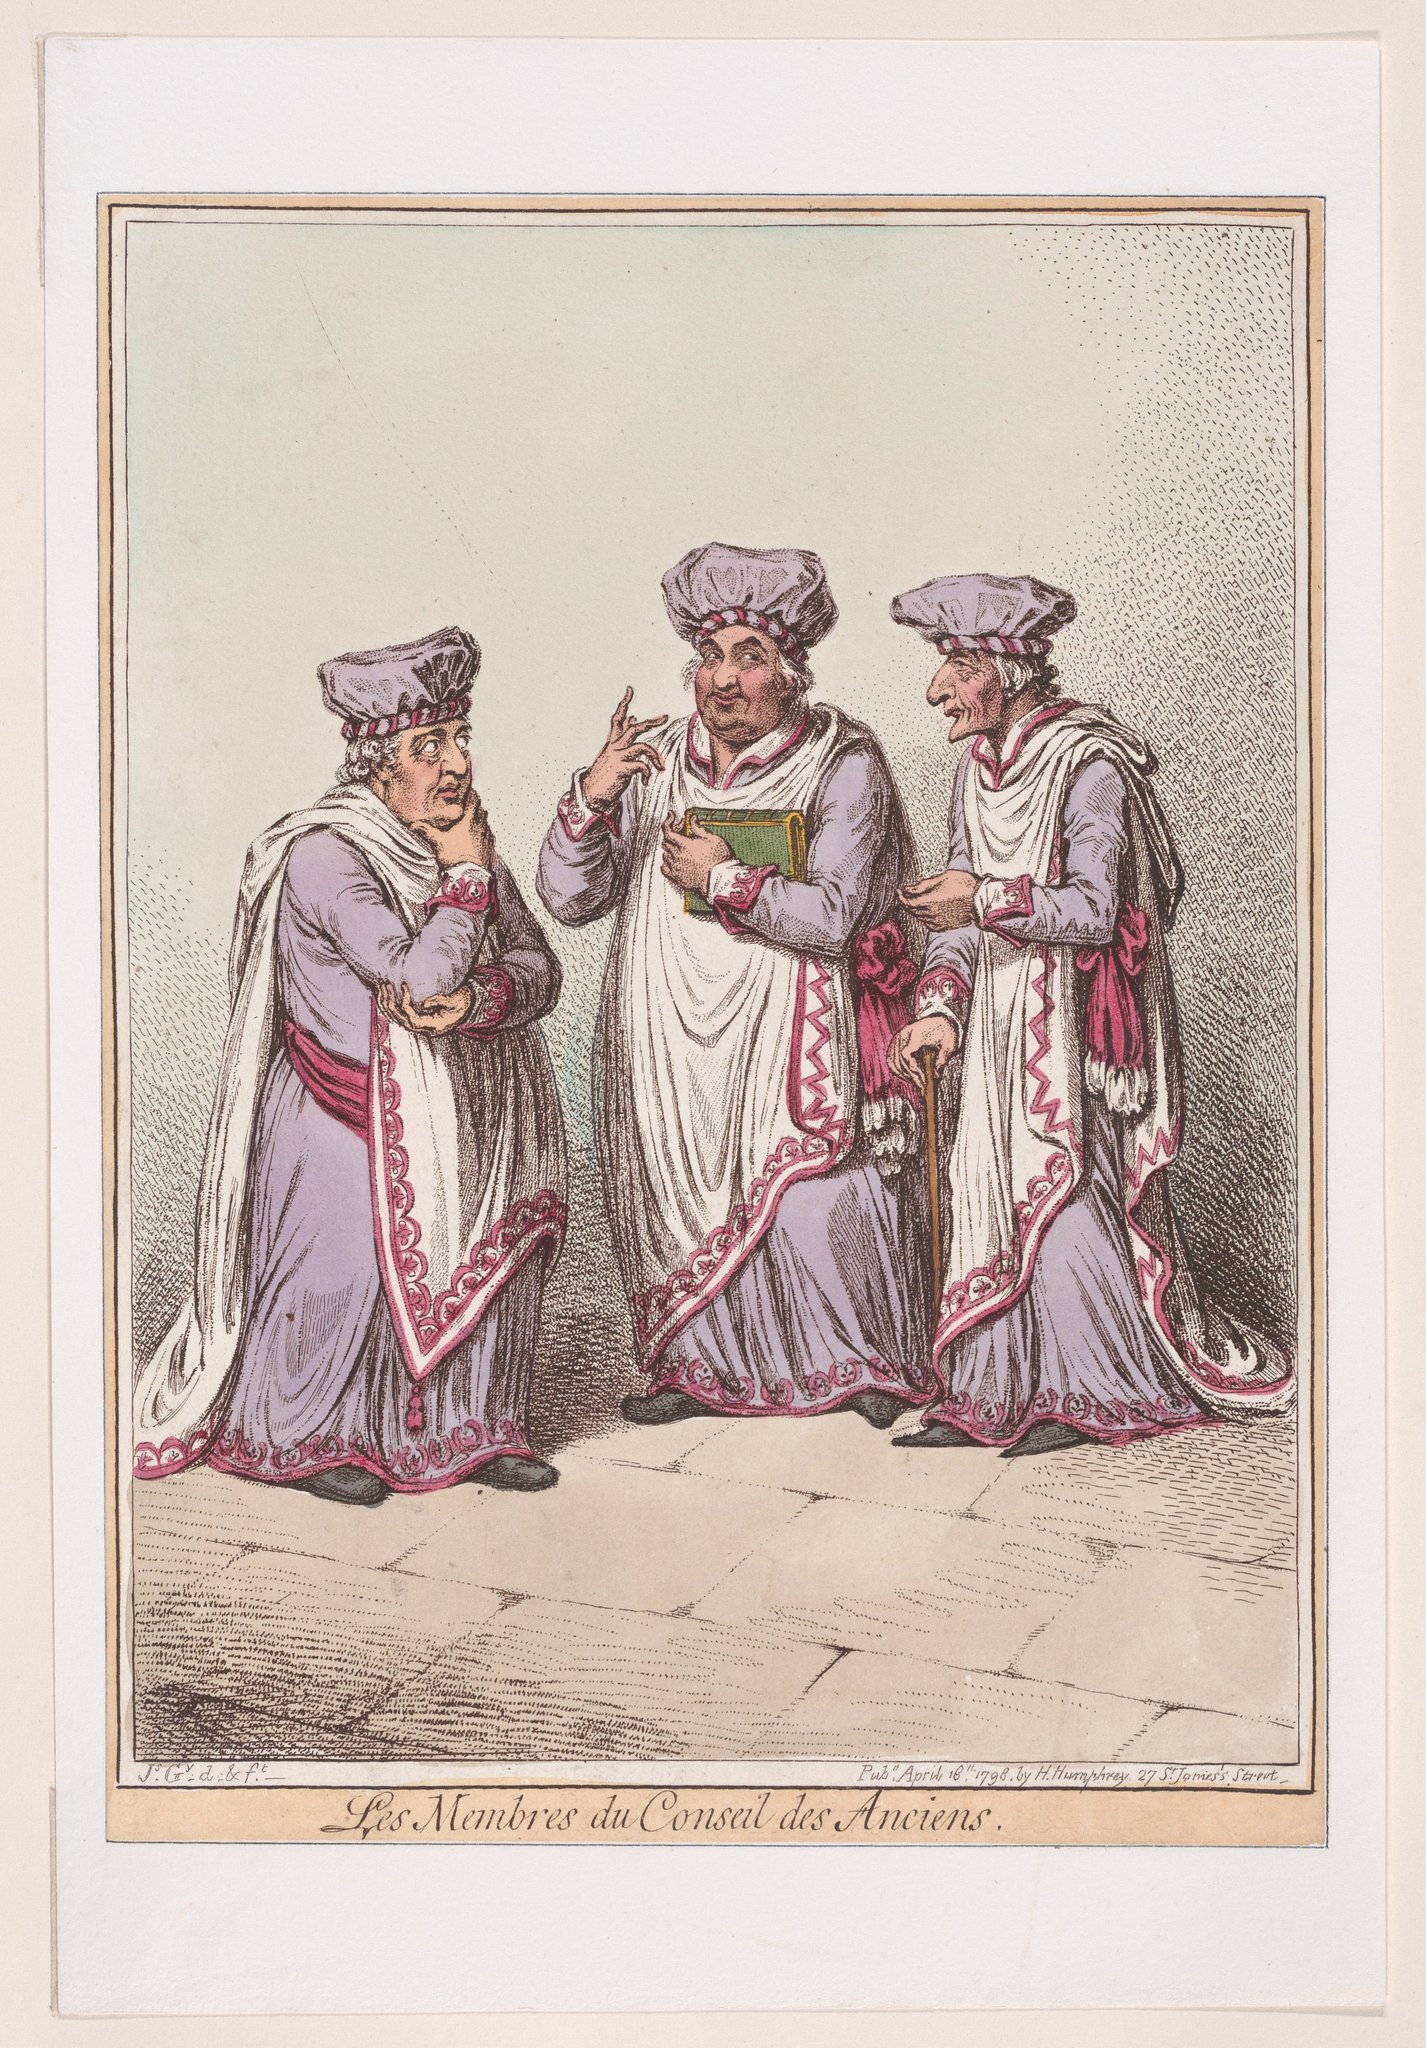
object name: print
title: French Habits, No. 2 - Les Membres du Conseil des Anciens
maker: james gillray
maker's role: artist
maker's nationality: british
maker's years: 1756-1815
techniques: etching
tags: men,caricature,politics